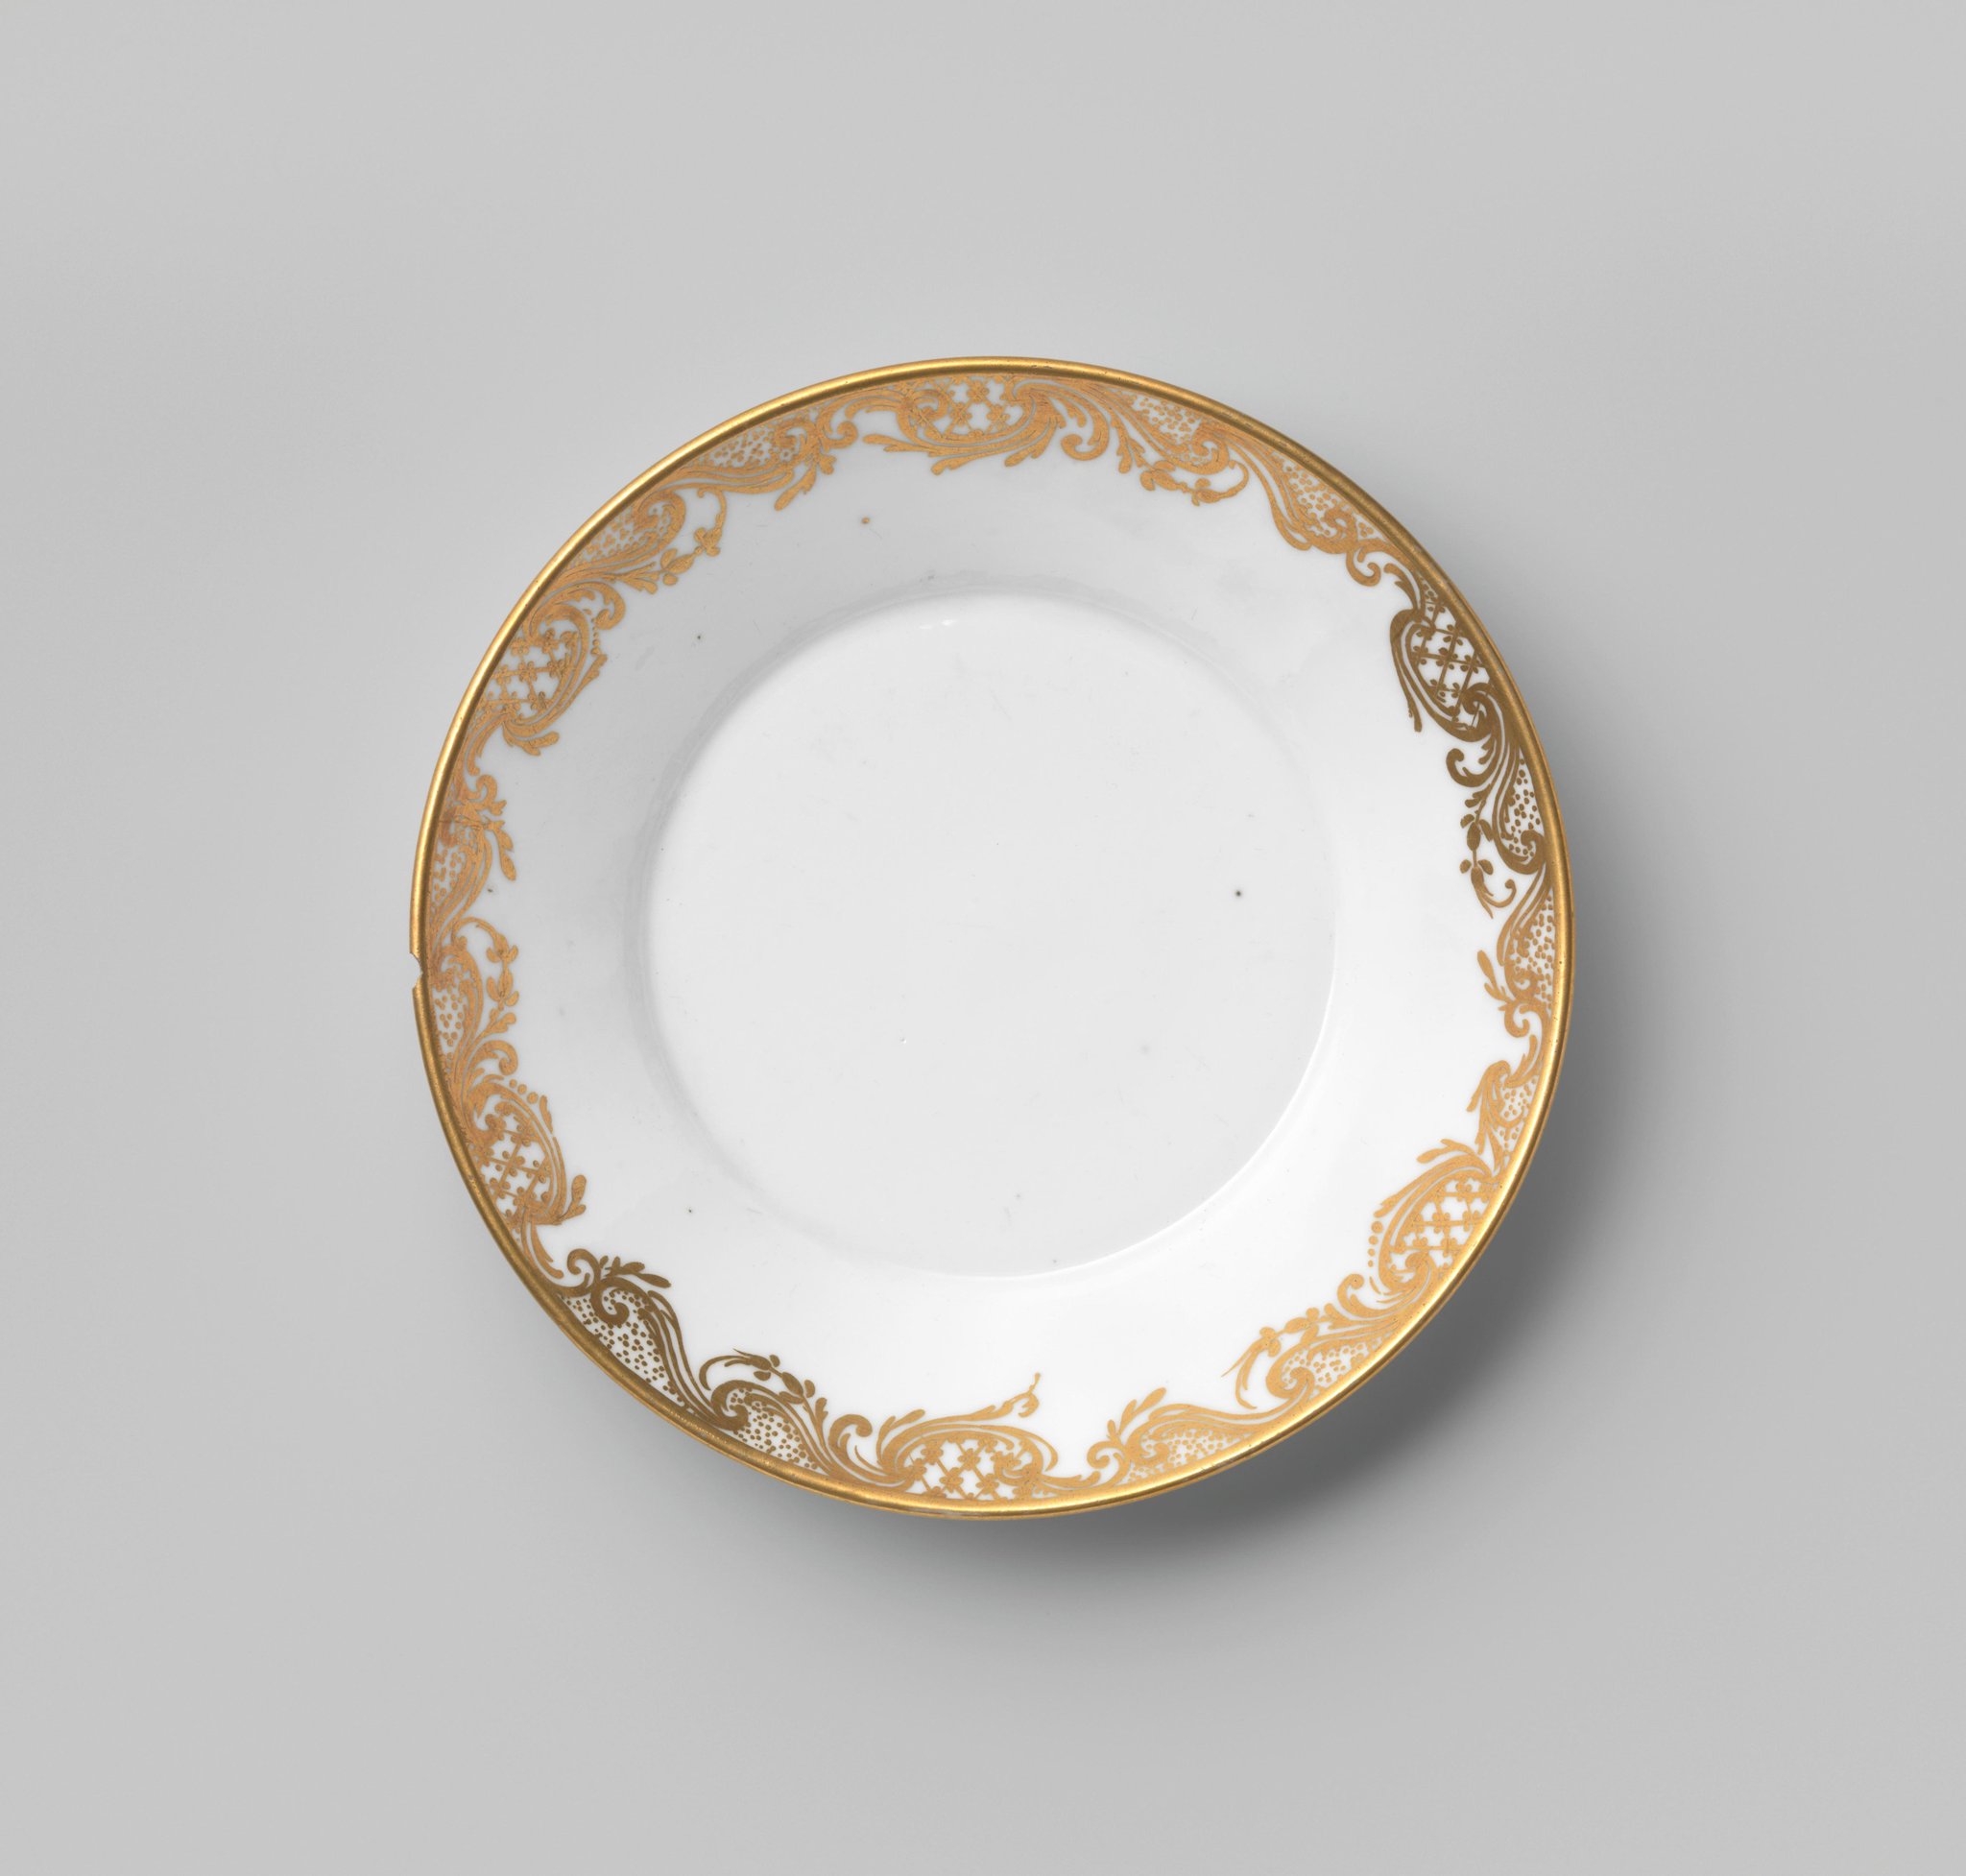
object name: platter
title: Saucer with a foliate scrolls and diaper pattern border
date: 1754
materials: glaze, gold, paint, porcelain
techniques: firing, forming, gilding, turning, vitrification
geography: vincennes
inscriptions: mark: ‘gekroonde dubbele L/ tweemaal gespiegelde C’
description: Schotel van porselein met een rechte wand, beschilderd op het glazuur in goud. Op de binnenrand een band met bladranken en servetwerk. Gouden rand. Gemerkt op de onderzijde met de gekroonde dubbele L, waaronder twee gespiegelde C's.